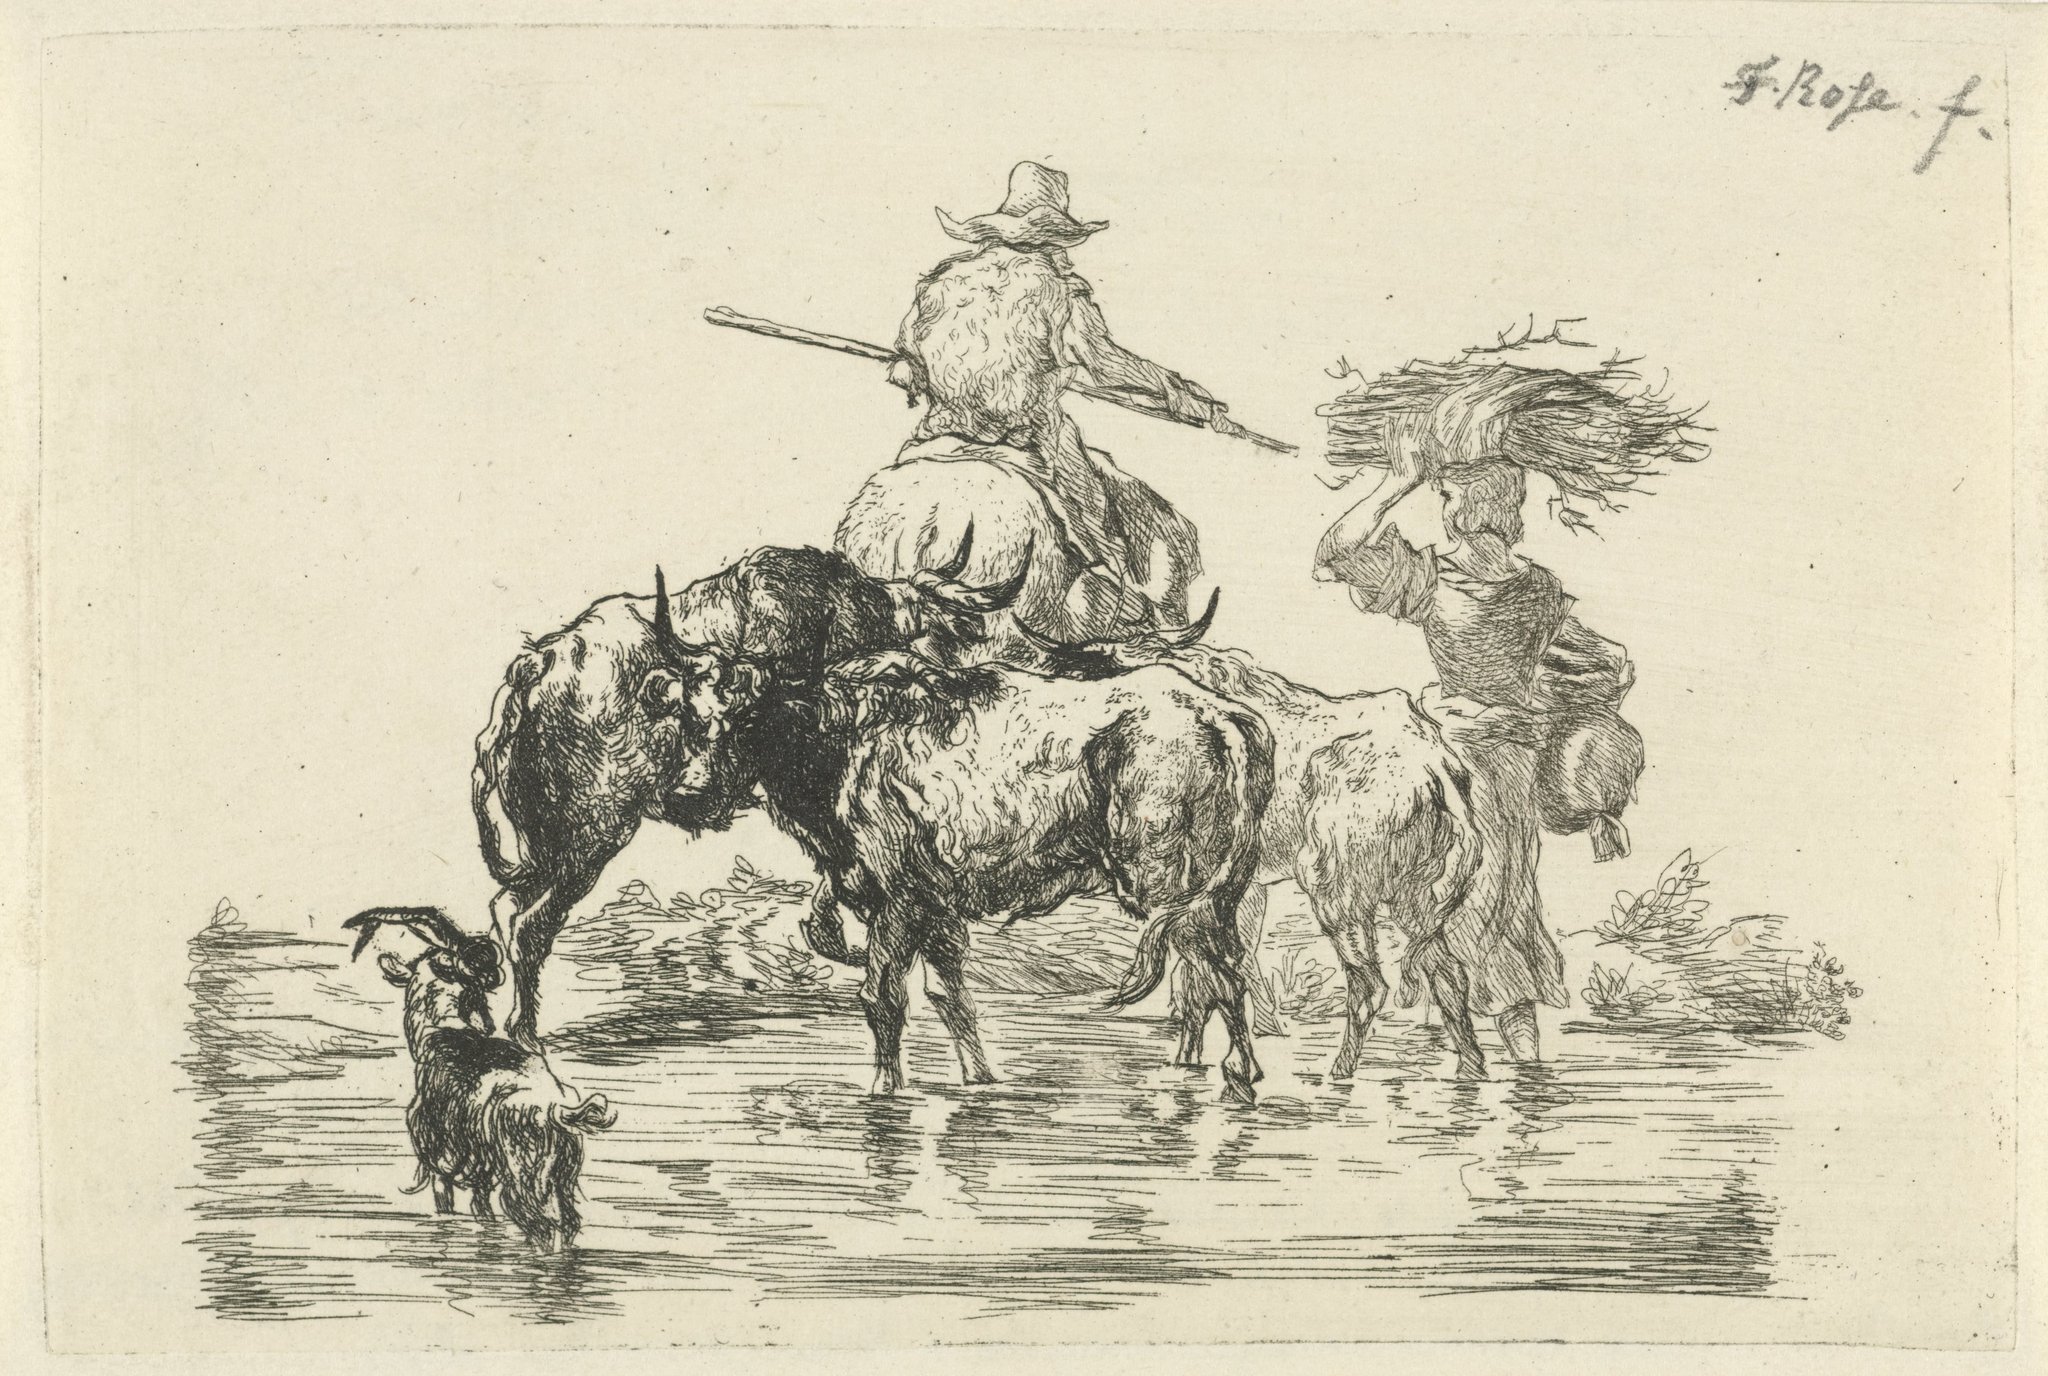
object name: print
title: Herder en herderin waden door een beek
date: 1826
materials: paper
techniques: drypoint, etching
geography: europe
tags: cow, herding, herdsman, herdswoman, shepherd, shepherdess, cowherd, etc., brook, goat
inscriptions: collector's mark: Lugt 2228, inscription: ‘Hij was de zoon van de Hr Rose, oud raad / van Hage / Zeer zeldzaam / [...]’, inscription: ‘Frederik Rose, dicipel van mij C. Kramm heeft [...] / in den jaren 1826 te Utrecht’, inscription: ‘is later naar O. Indien vertrokken / doch [...] 1864’, inscription: ‘F Rose f.’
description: Een herder en een herderin waden met hun vee door een beek. De herderin draagt een bos takken op het hoofd.